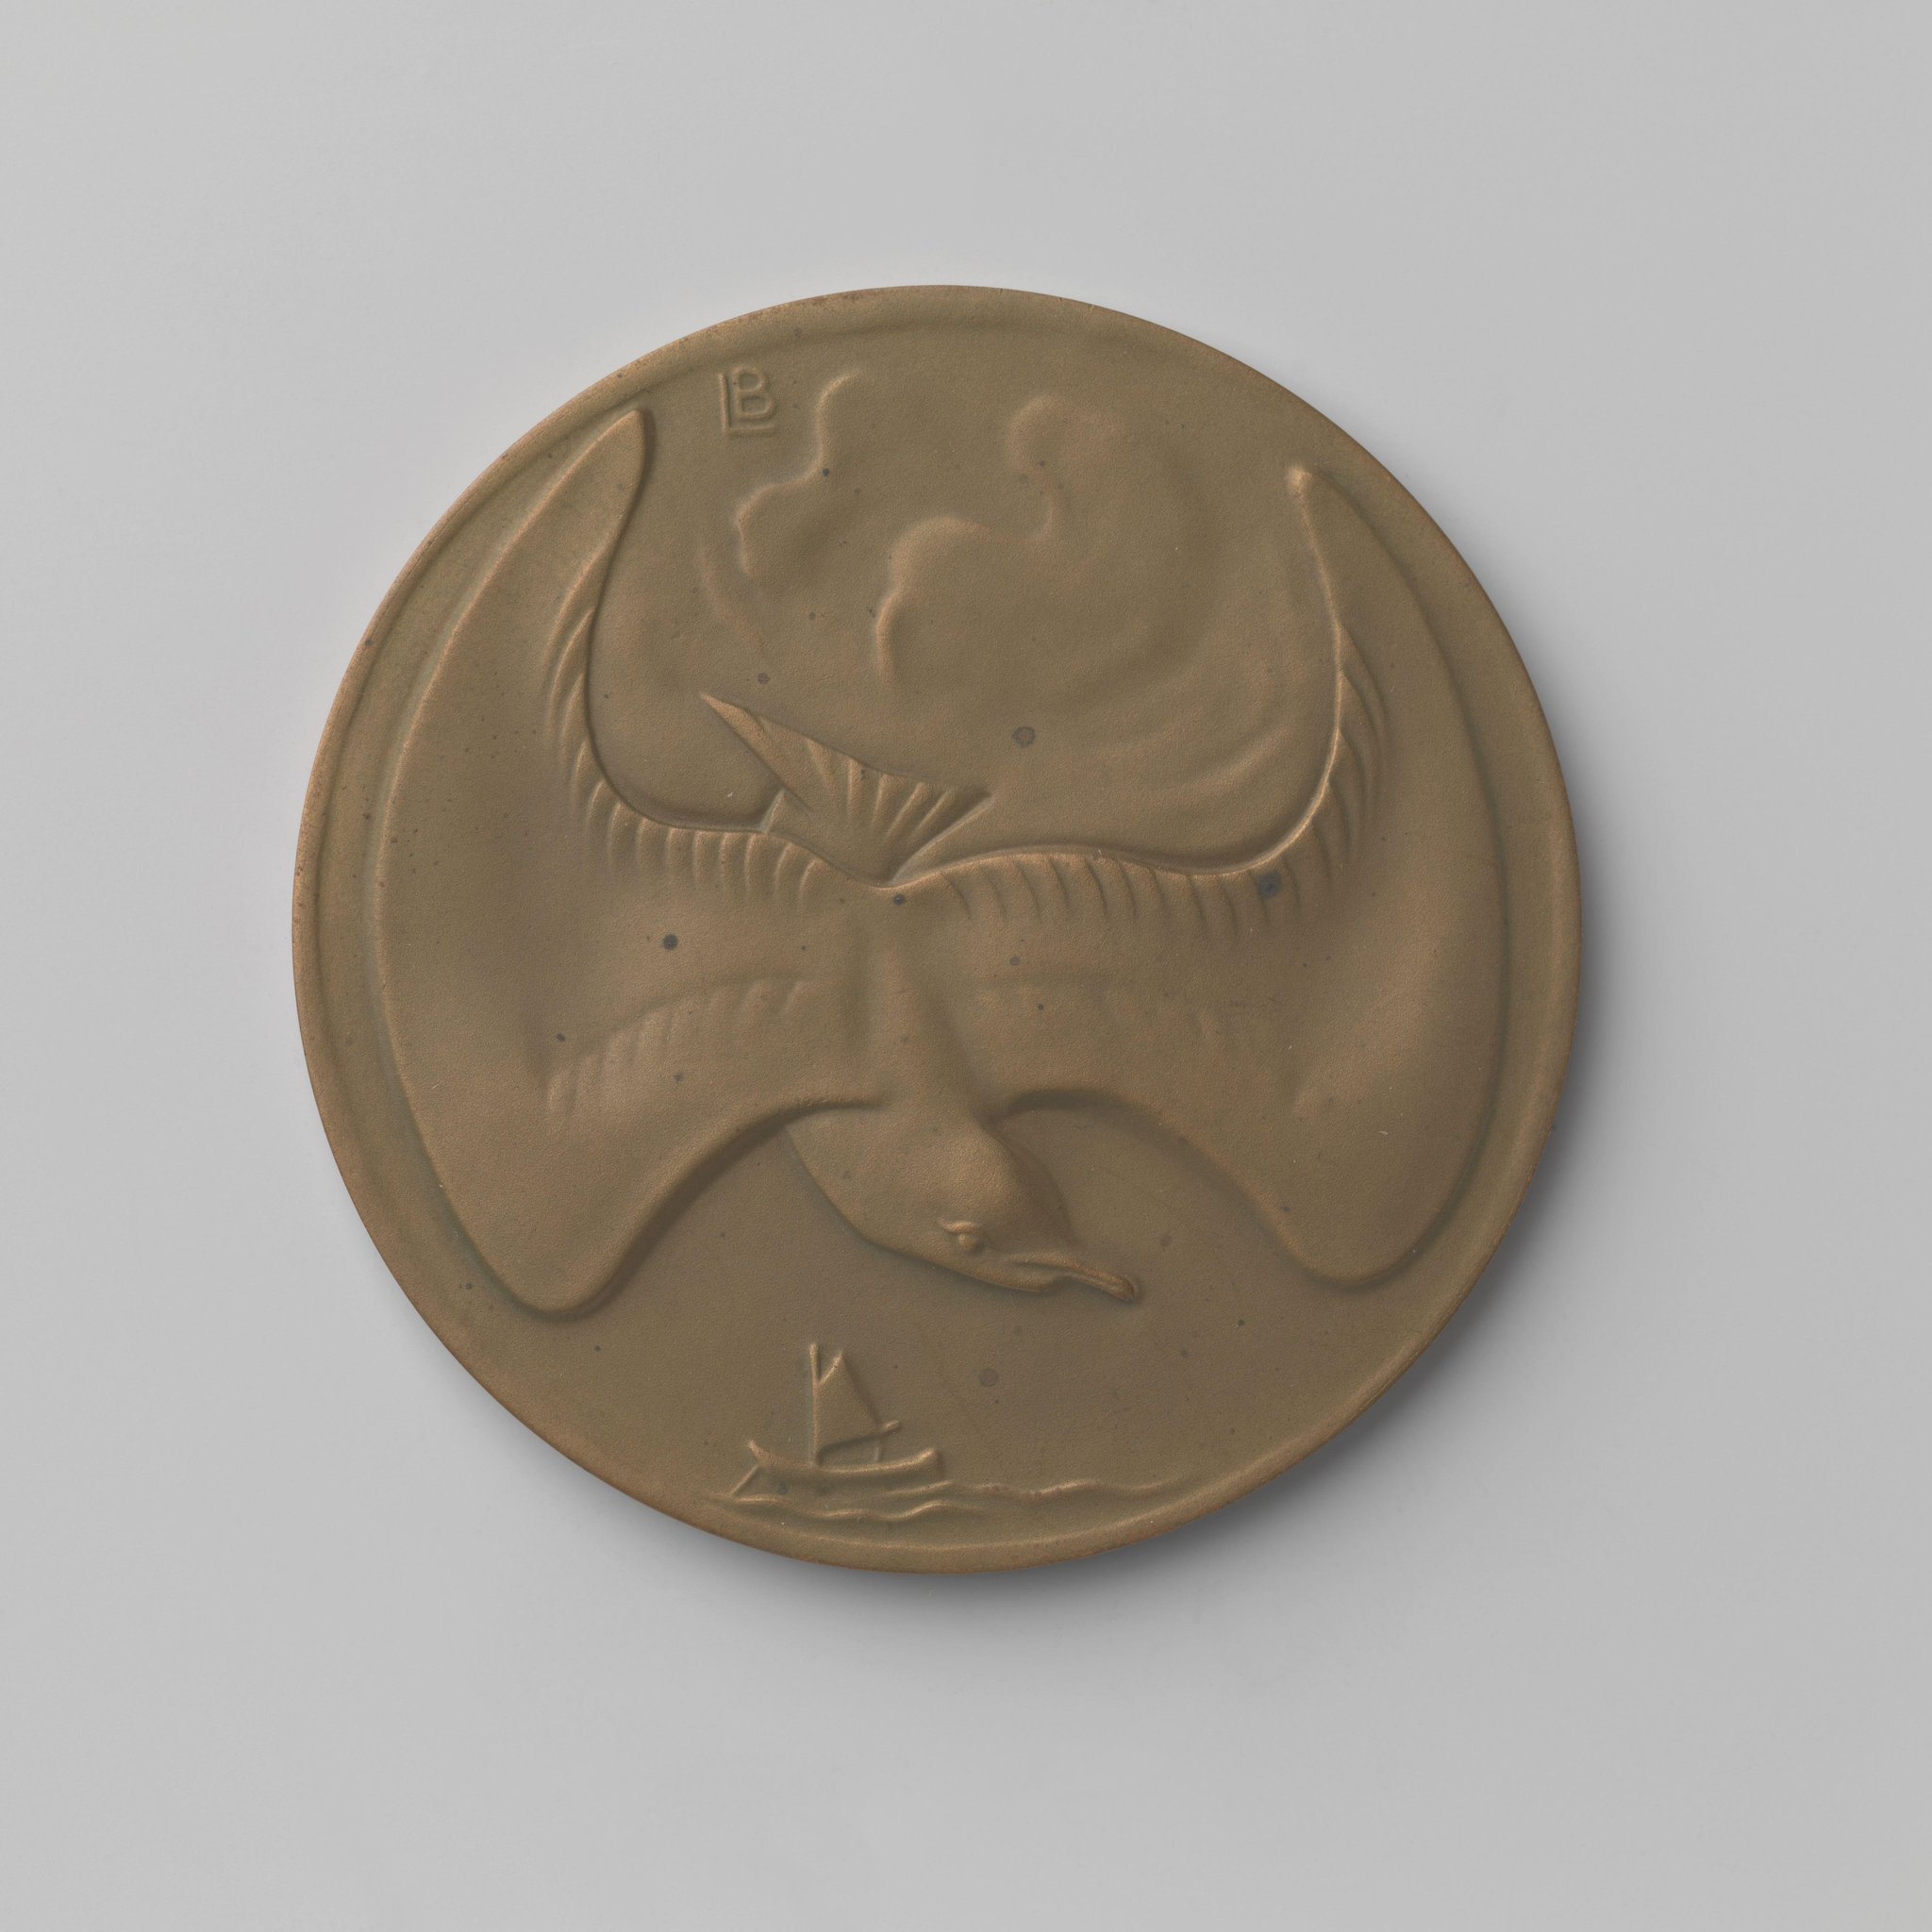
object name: history medal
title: Lucht en water (Vereniging voor Penningkunst 1934, eerste penning)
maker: leendert bolle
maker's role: painter, sculptor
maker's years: 1879-1942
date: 1934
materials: bronze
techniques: striking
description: Bronzen penning, op de voorzijde een vogel boven zee, op de keerzijde twee vissen, met verklaring.